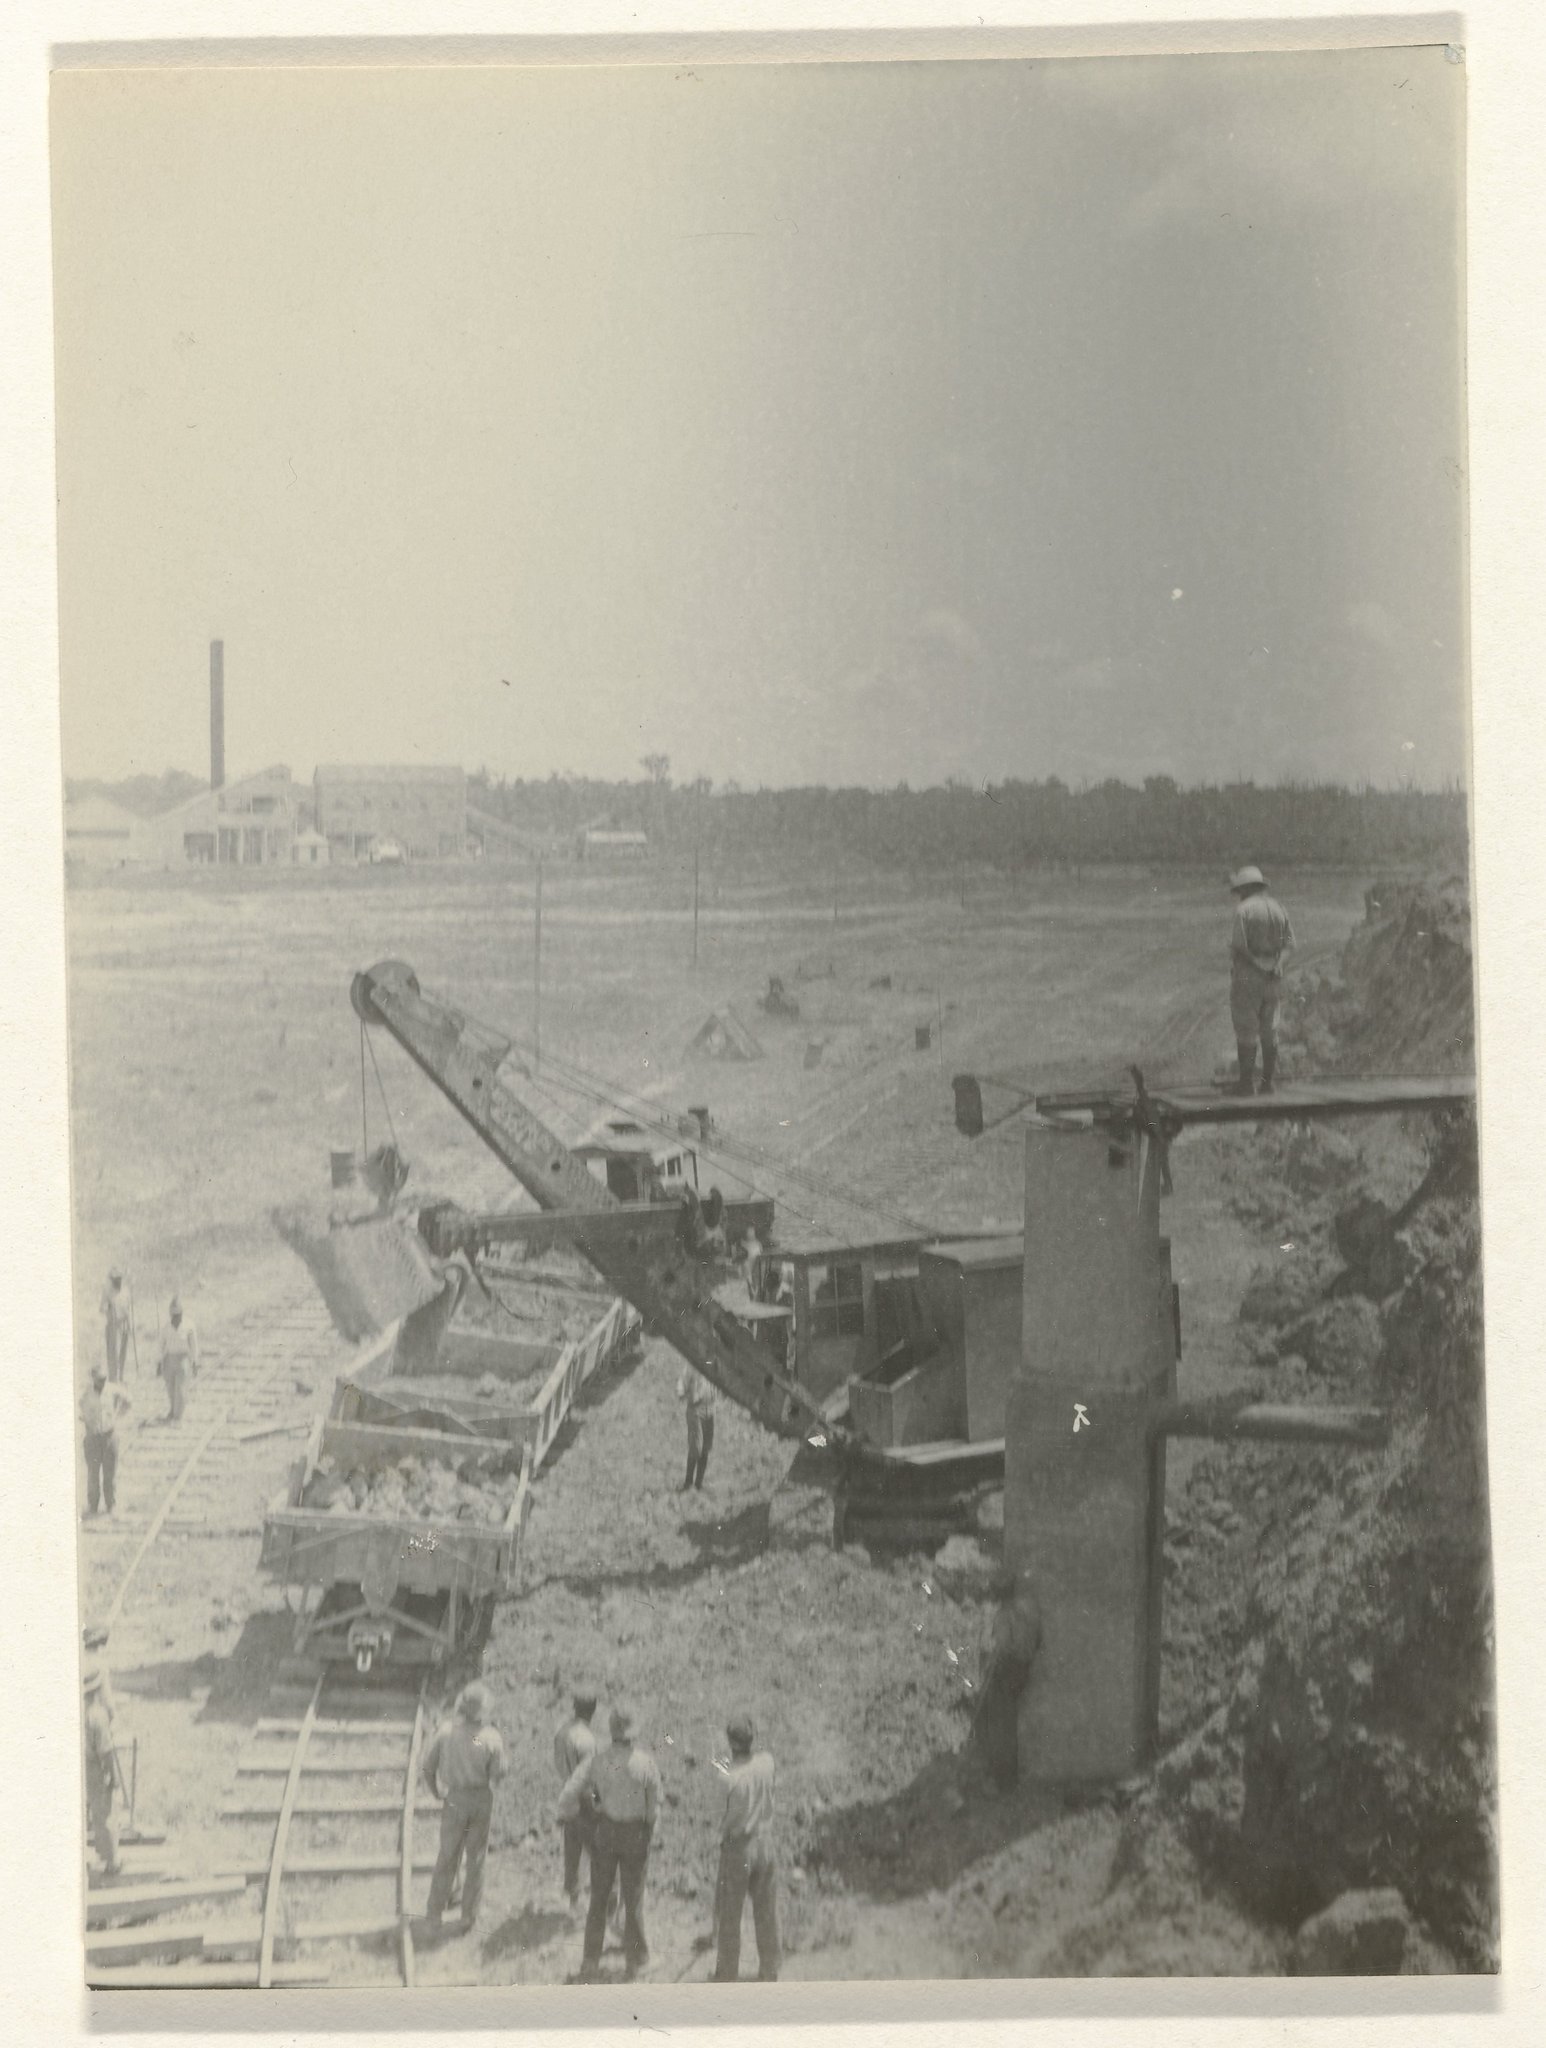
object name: photograph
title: Bauxiet wordt geladen in wagons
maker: Anonymous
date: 1929-1930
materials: photographic support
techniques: photography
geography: suriname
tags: opencast mine; strip mining